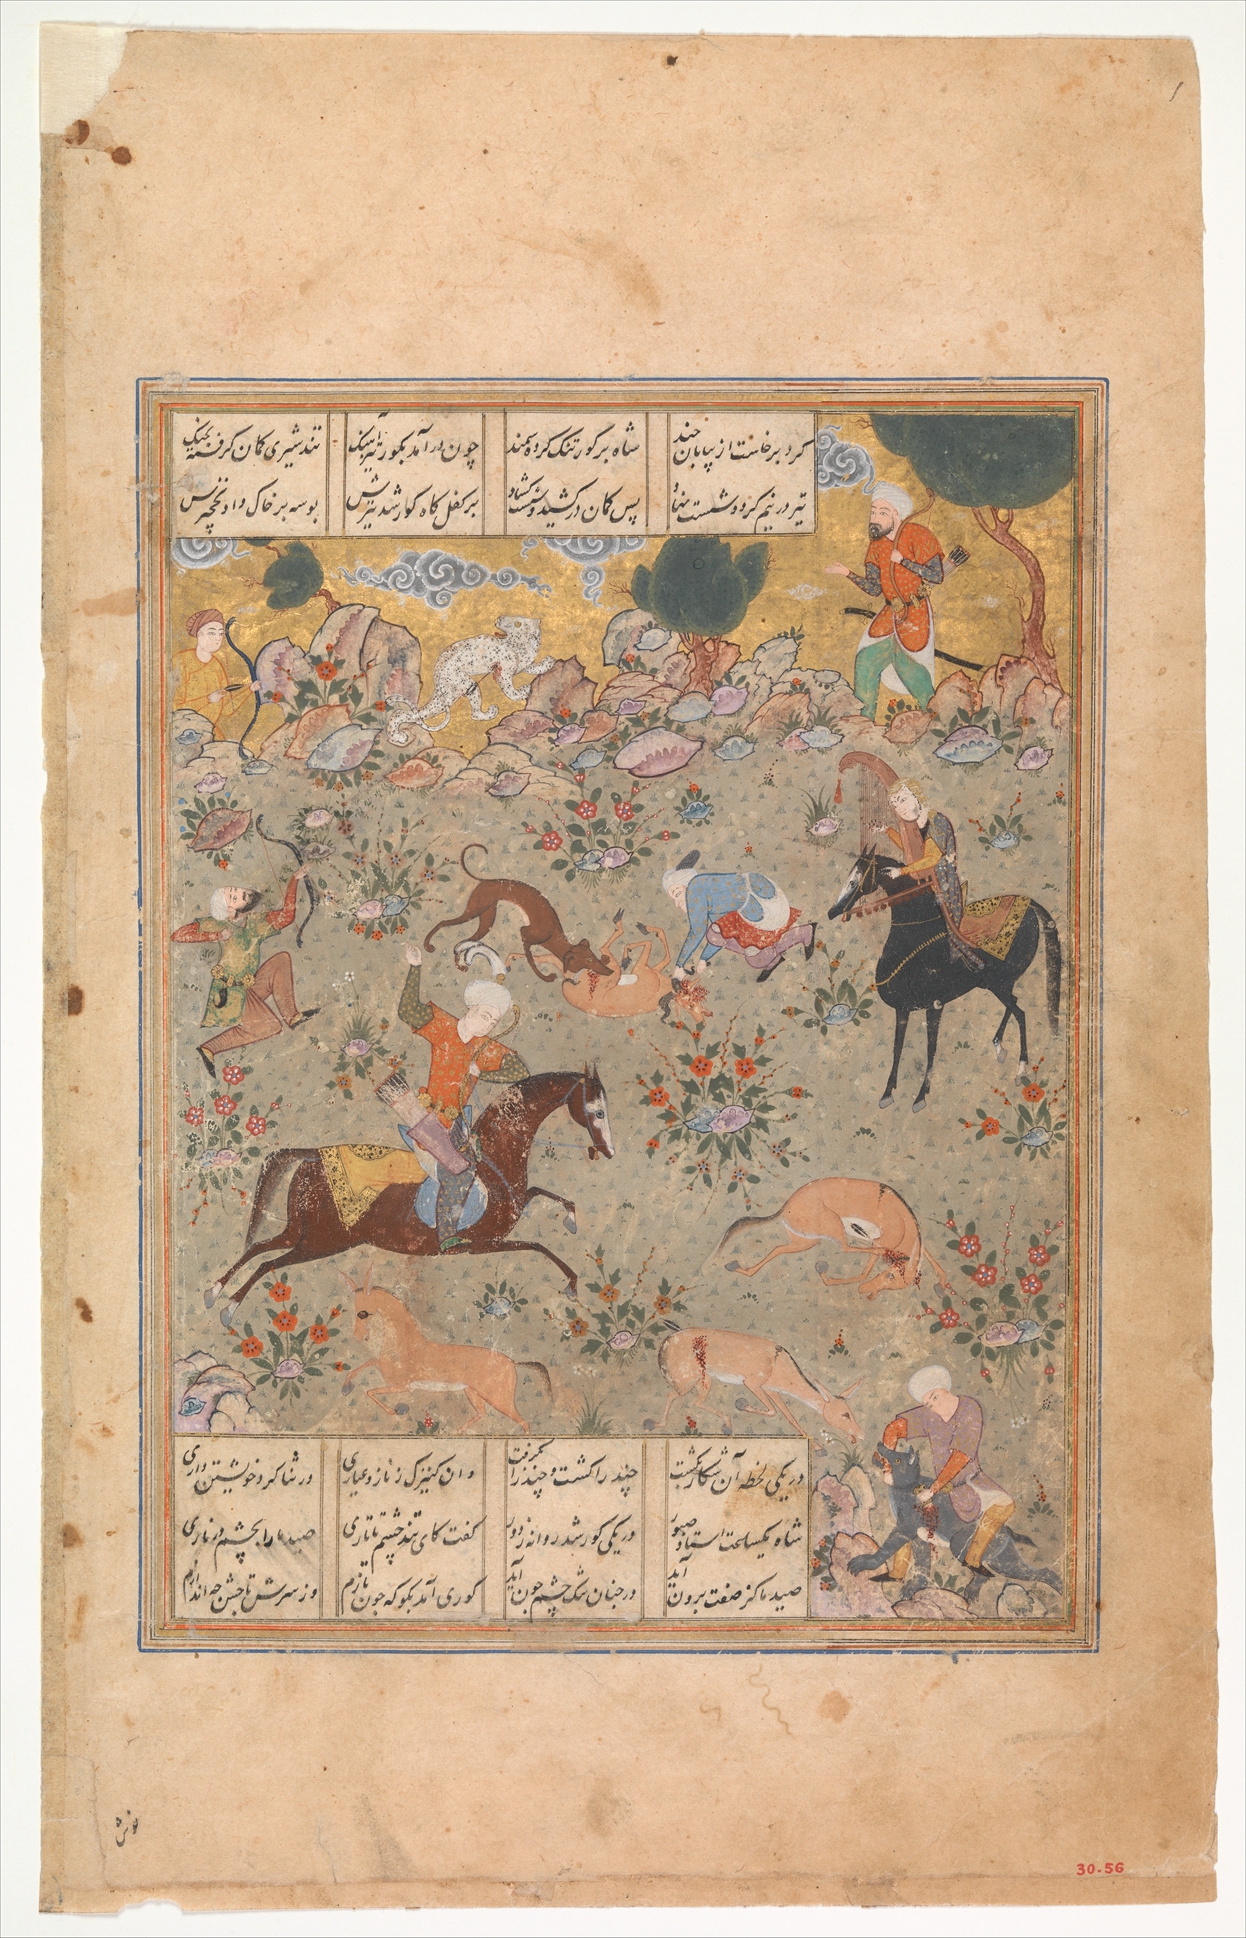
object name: folio from an illustrated manuscript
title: "Bahram Gur Shows His Skill Hunting, while Fitna Watches", Folio from a Haft Paykar (Seven Portraits) of Nizami of Ganja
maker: nizami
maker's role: author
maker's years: 1141-1209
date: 1534-1566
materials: gold, ink, paper, watercolor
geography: iran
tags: kings,women,hunting,horses